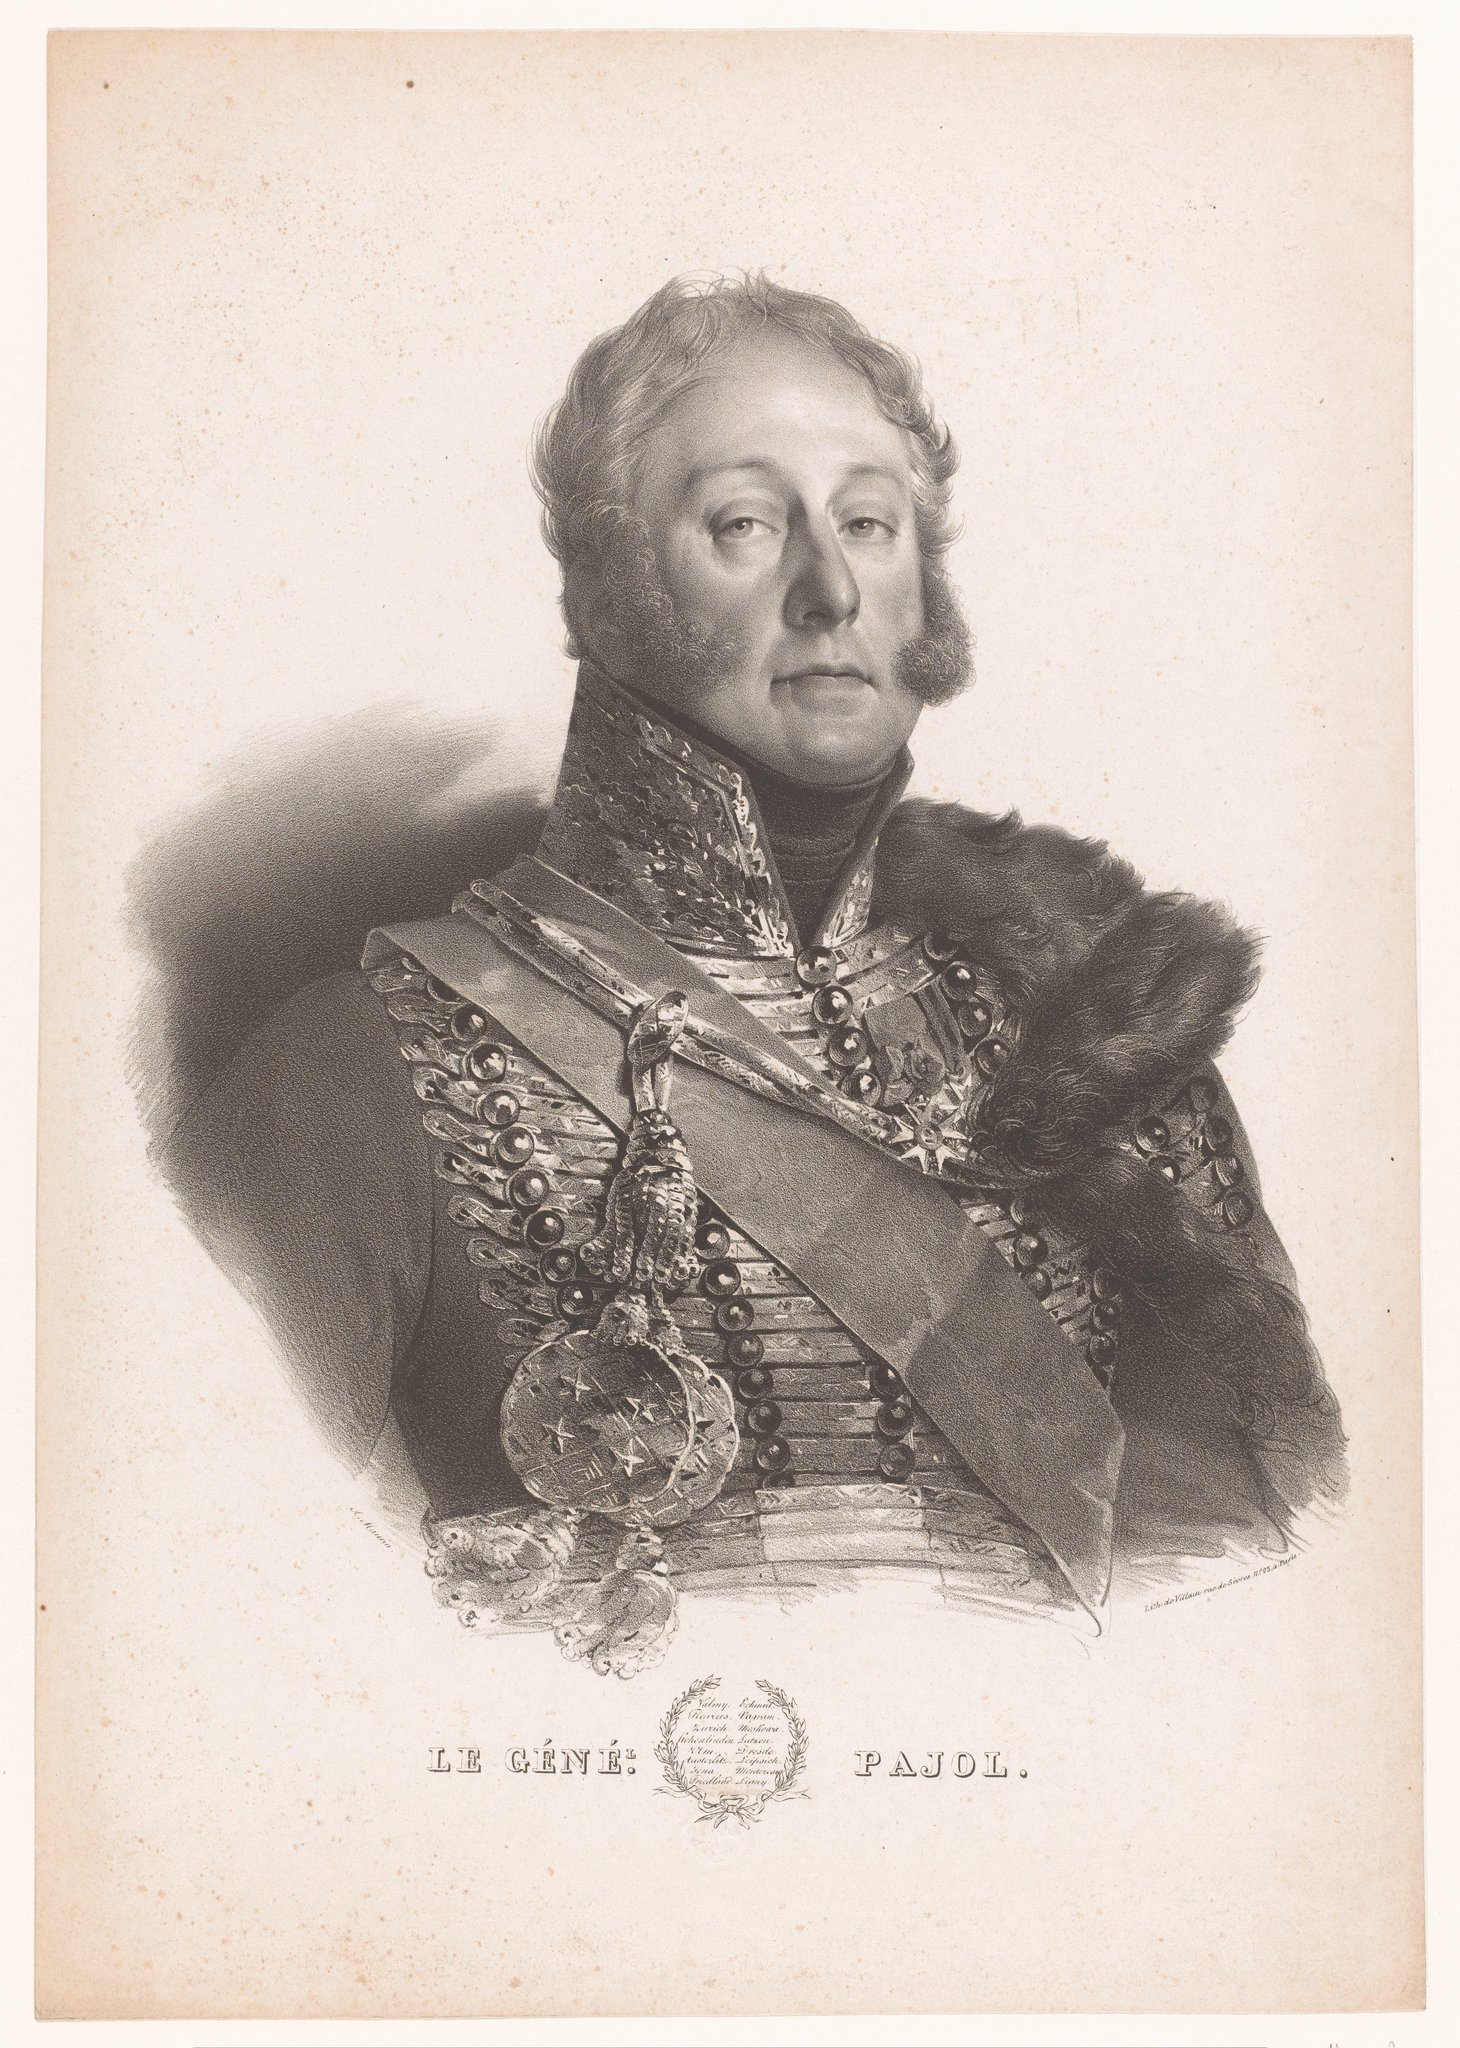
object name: print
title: Portret van Pierre Claude Pajol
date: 1825-1833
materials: paper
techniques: lithograph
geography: paris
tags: paris, politician, commander-in-chief, general, marshal, historical persons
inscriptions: collector's mark: Lugt 2228, check stamp: Lugt 619